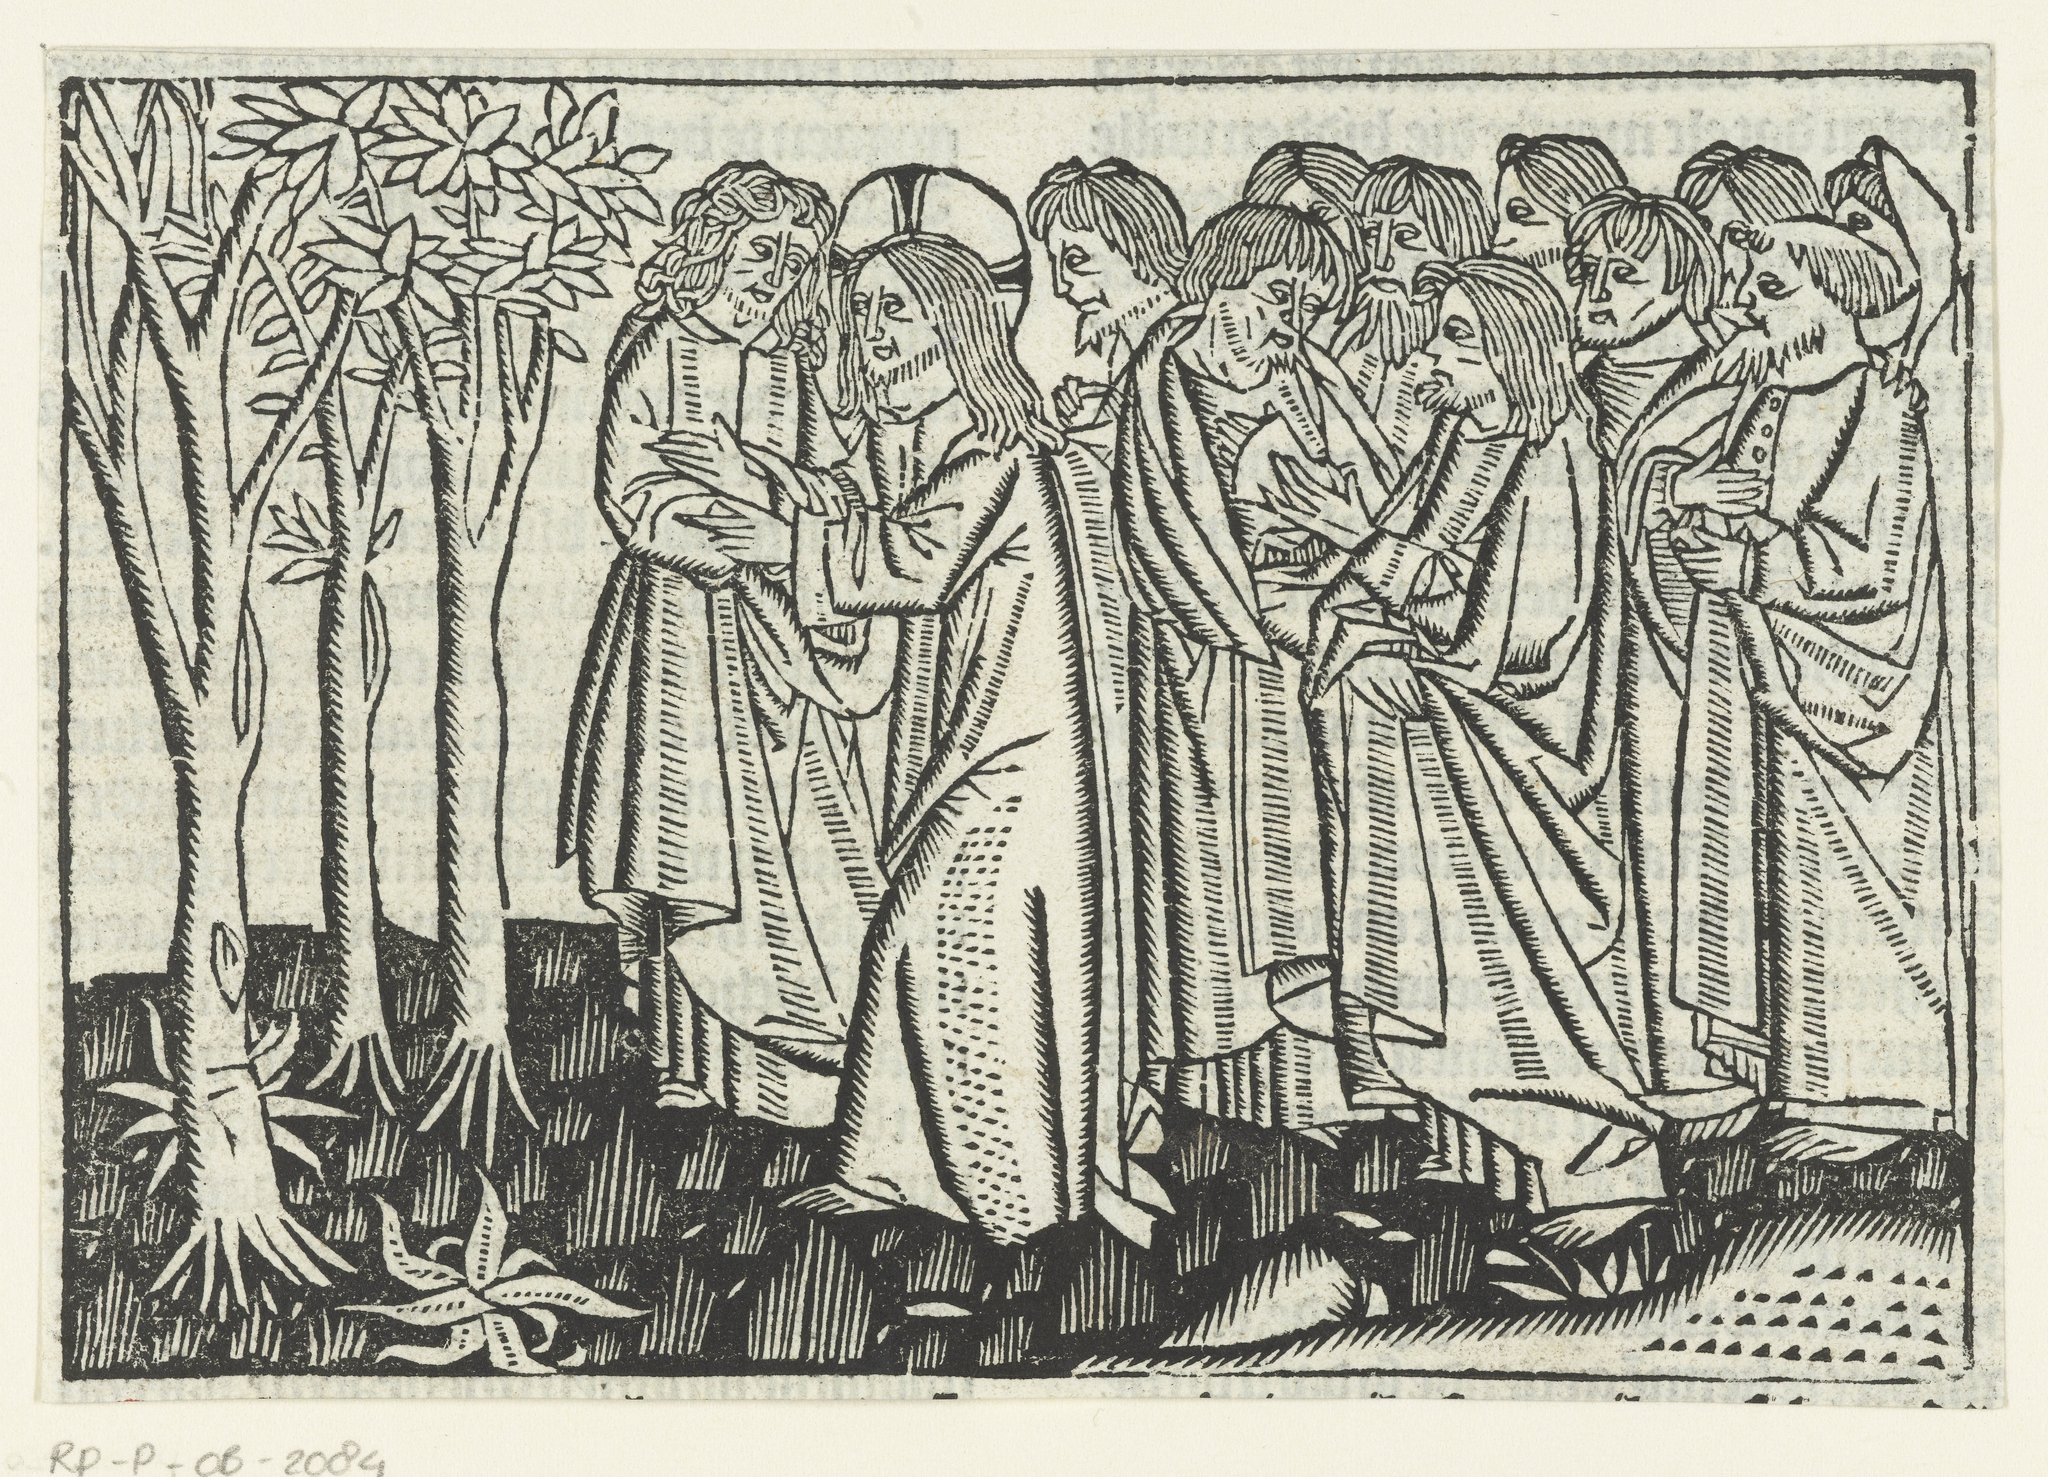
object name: book illustration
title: Christus vervloekt de vijgeboom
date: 1480-1500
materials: paper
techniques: woodcut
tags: the cursing of the fig-tree (matthew 21:18-22; mark 11:12-14, 11:20-21)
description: Eén blad van 113 uit Ludolphus de Saxonia, "Dit es dleué ons liefs heeren ihesu christi". Anonieme Nederlandse vertaling. Uitgegeven door Henrick Eckert van Homberch te Antwerpen in 1503. Botke, K. Deze 113 houtsneden, die meestal reeds in vroege Nederlandse boeken gebruikt zijn, worden toegeschreven aan de tweede Meester van Delft, de Meester van de Delbecq-Schreiber-passie en de Meester van de Virgo inter Virgines. In Conway (1884) en in "De gulden passer"(1951) zijn ook eerdere versies opgenomen. Botke, K.